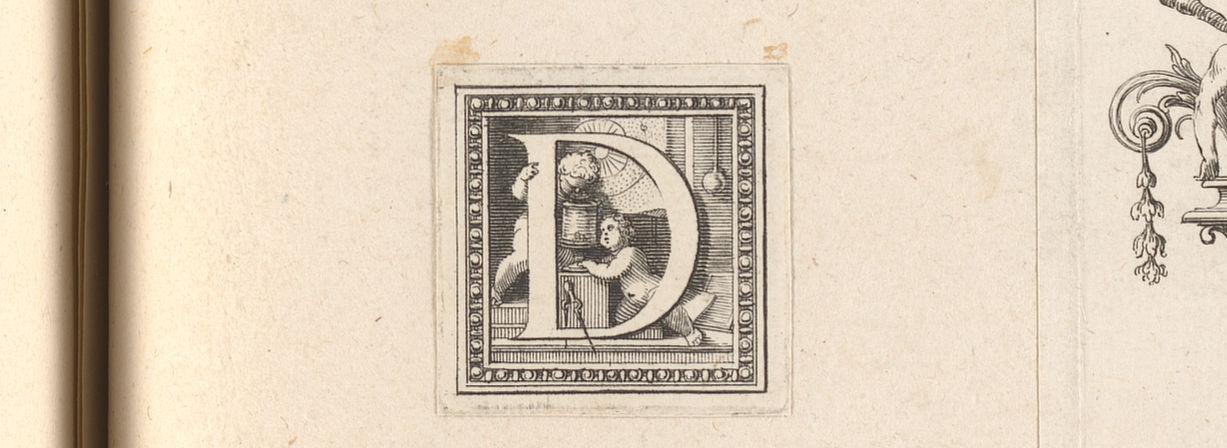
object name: print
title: Initiaal 'D' met twee putti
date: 1707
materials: paper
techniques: etching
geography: paris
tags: initial, cupids: 'amores', 'amoretti', 'putti'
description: Prent uit: Noailles, Jules-Adrien de. Theses philosophicae (...). Parijs: Jacques Quillau, 1707.